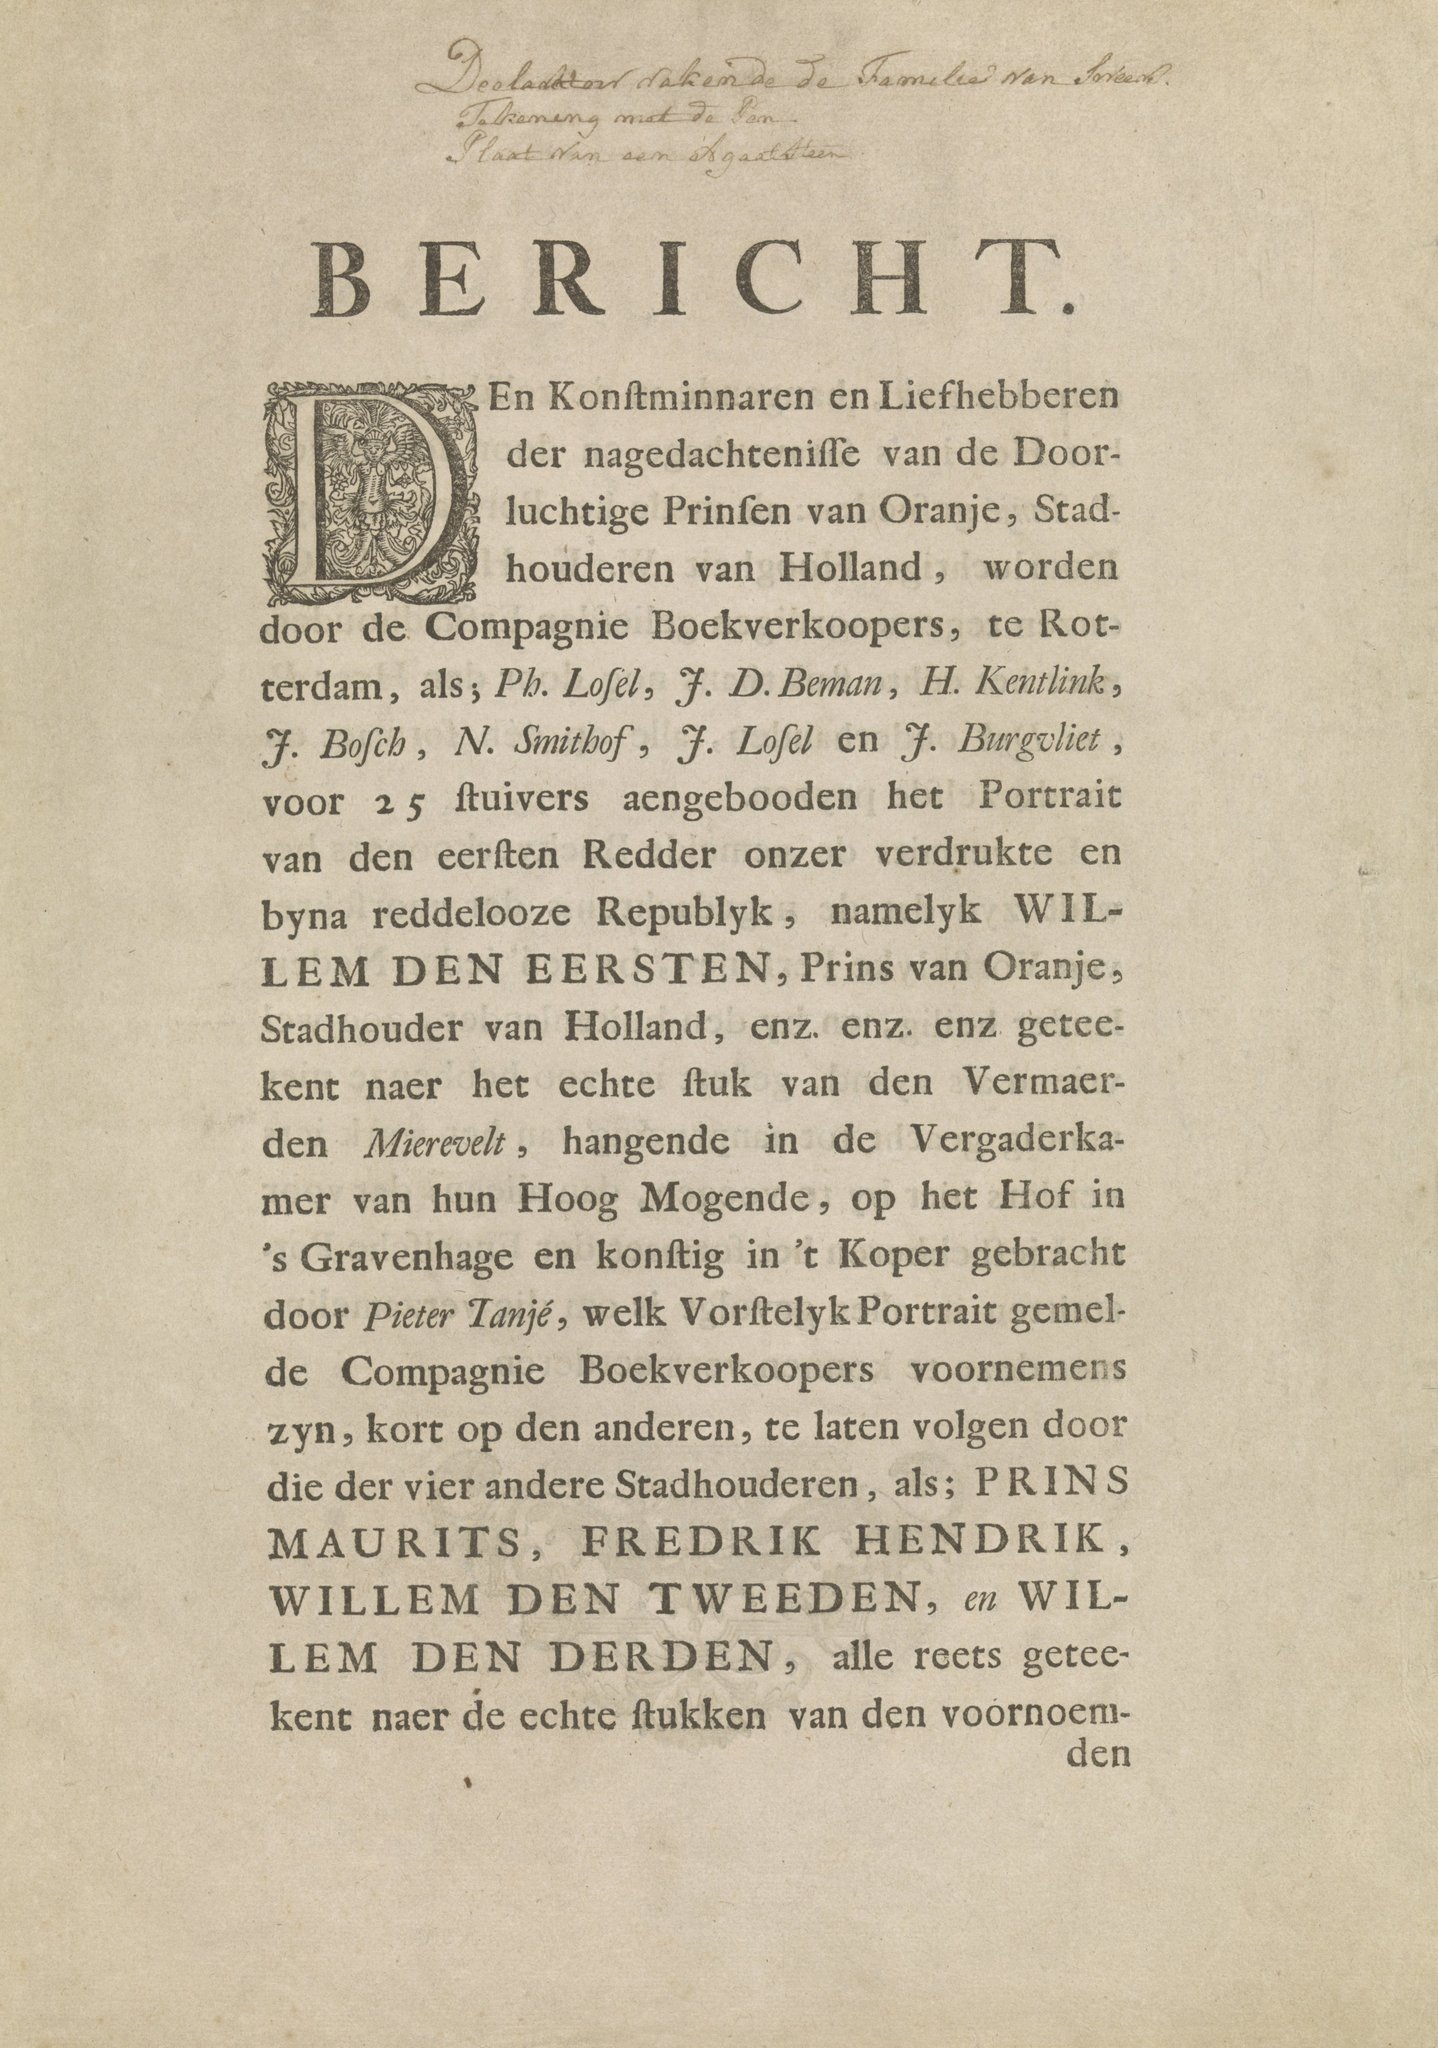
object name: uitgeversprospectus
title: Bericht bij de uitgave van zes portretten van stadhouders en vorsten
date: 1748-1751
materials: paper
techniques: letterpress printing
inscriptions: collector's mark: Lugt 2228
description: Bericht bij de uitgave van zes portretten van stadhouders en vorsten door Pieter Tanjé gegraveerd.